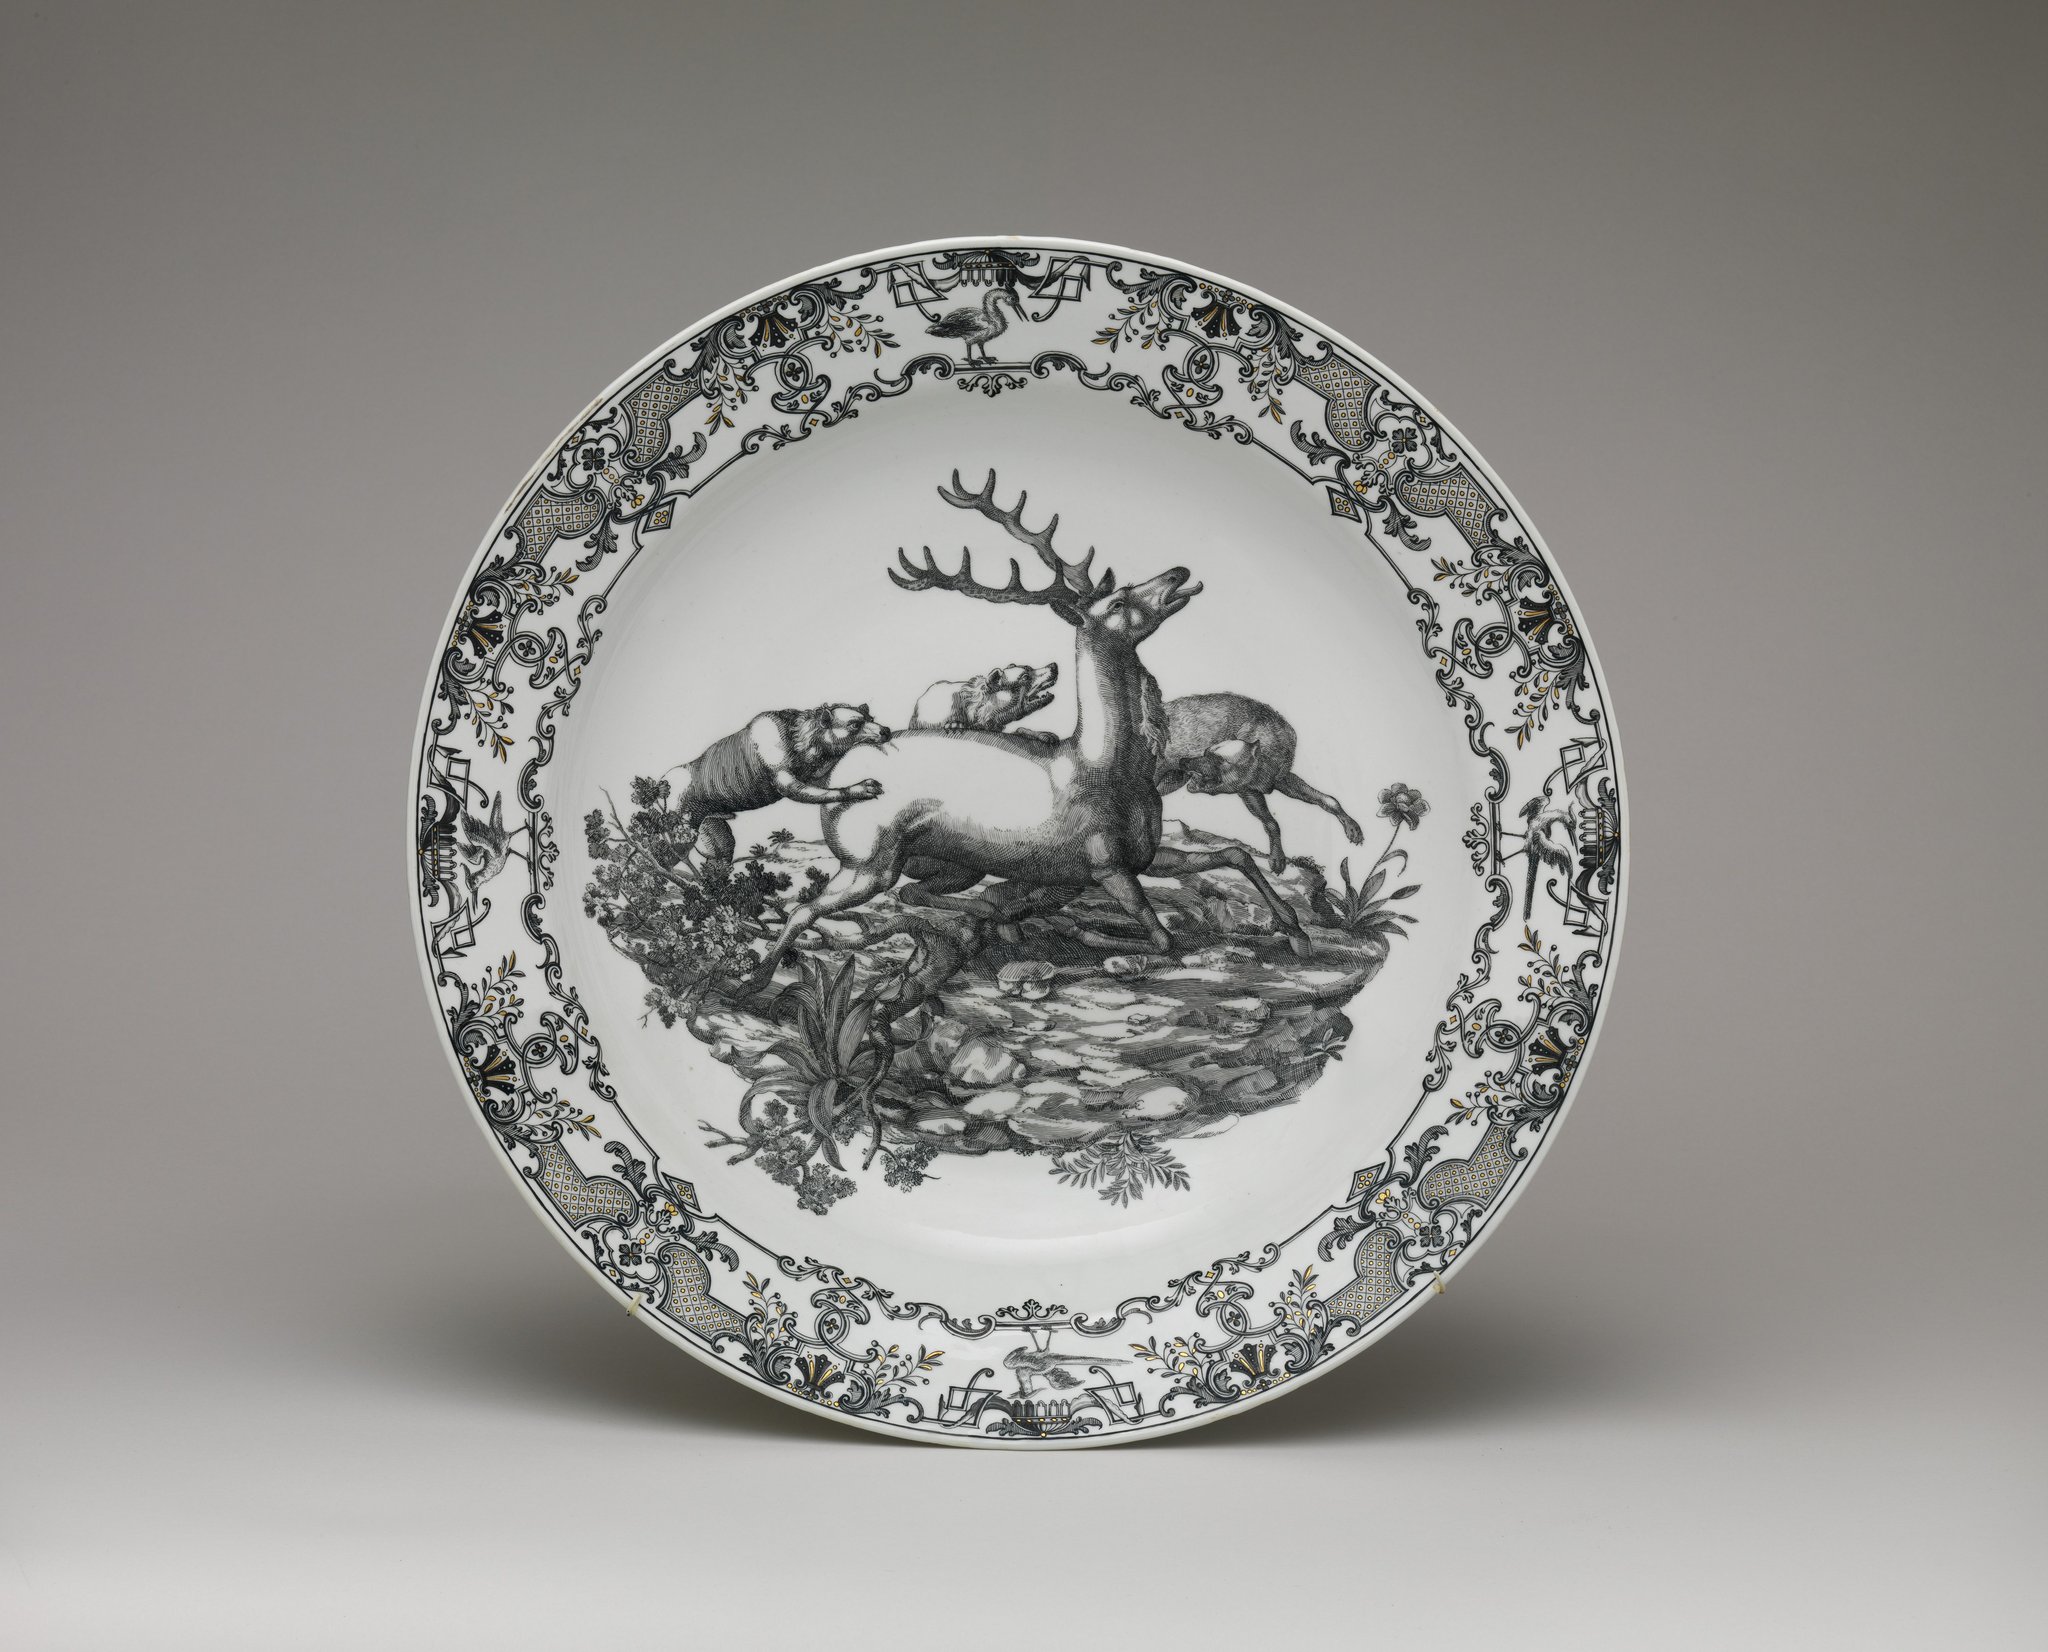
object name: charger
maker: vienna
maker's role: manufactory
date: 1735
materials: hard paste porcelain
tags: deer